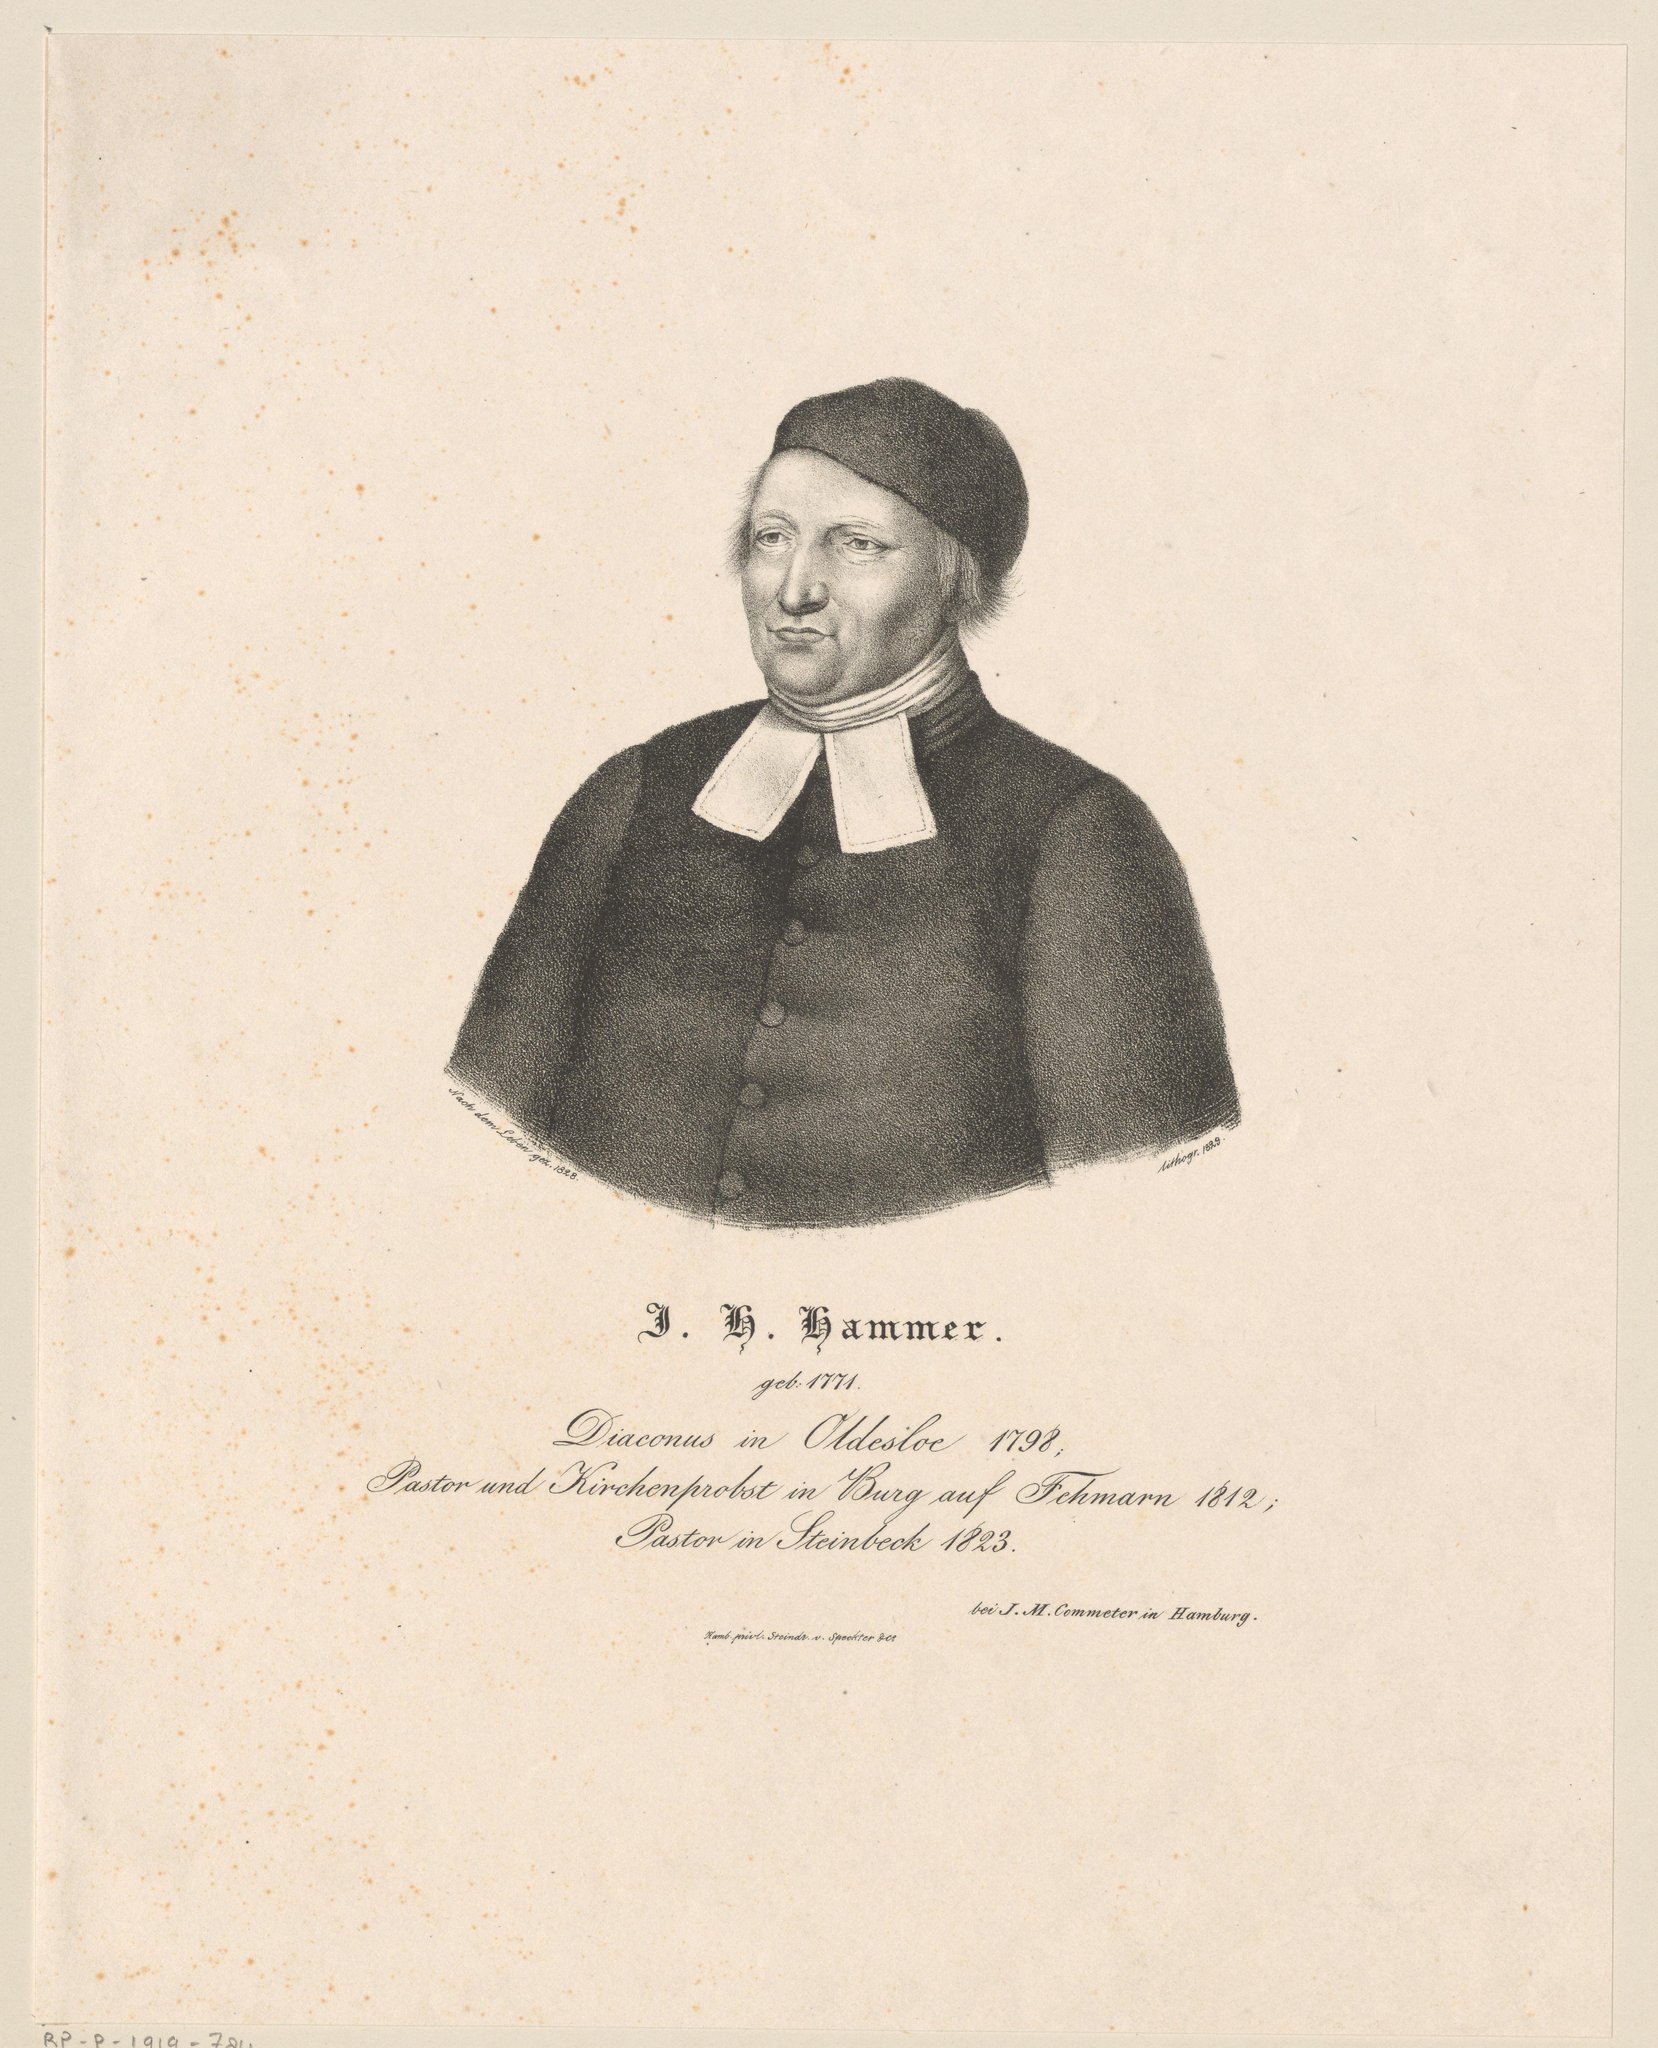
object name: print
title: Portret van J.H. Hammer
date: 1829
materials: paper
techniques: lithograph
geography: hamburg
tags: historical persons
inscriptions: collector's mark: Lugt 2228